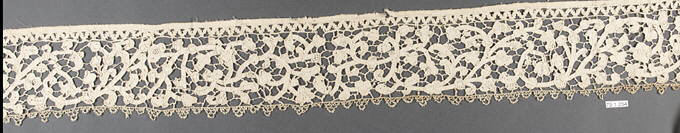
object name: strip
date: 1701-1733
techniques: lace